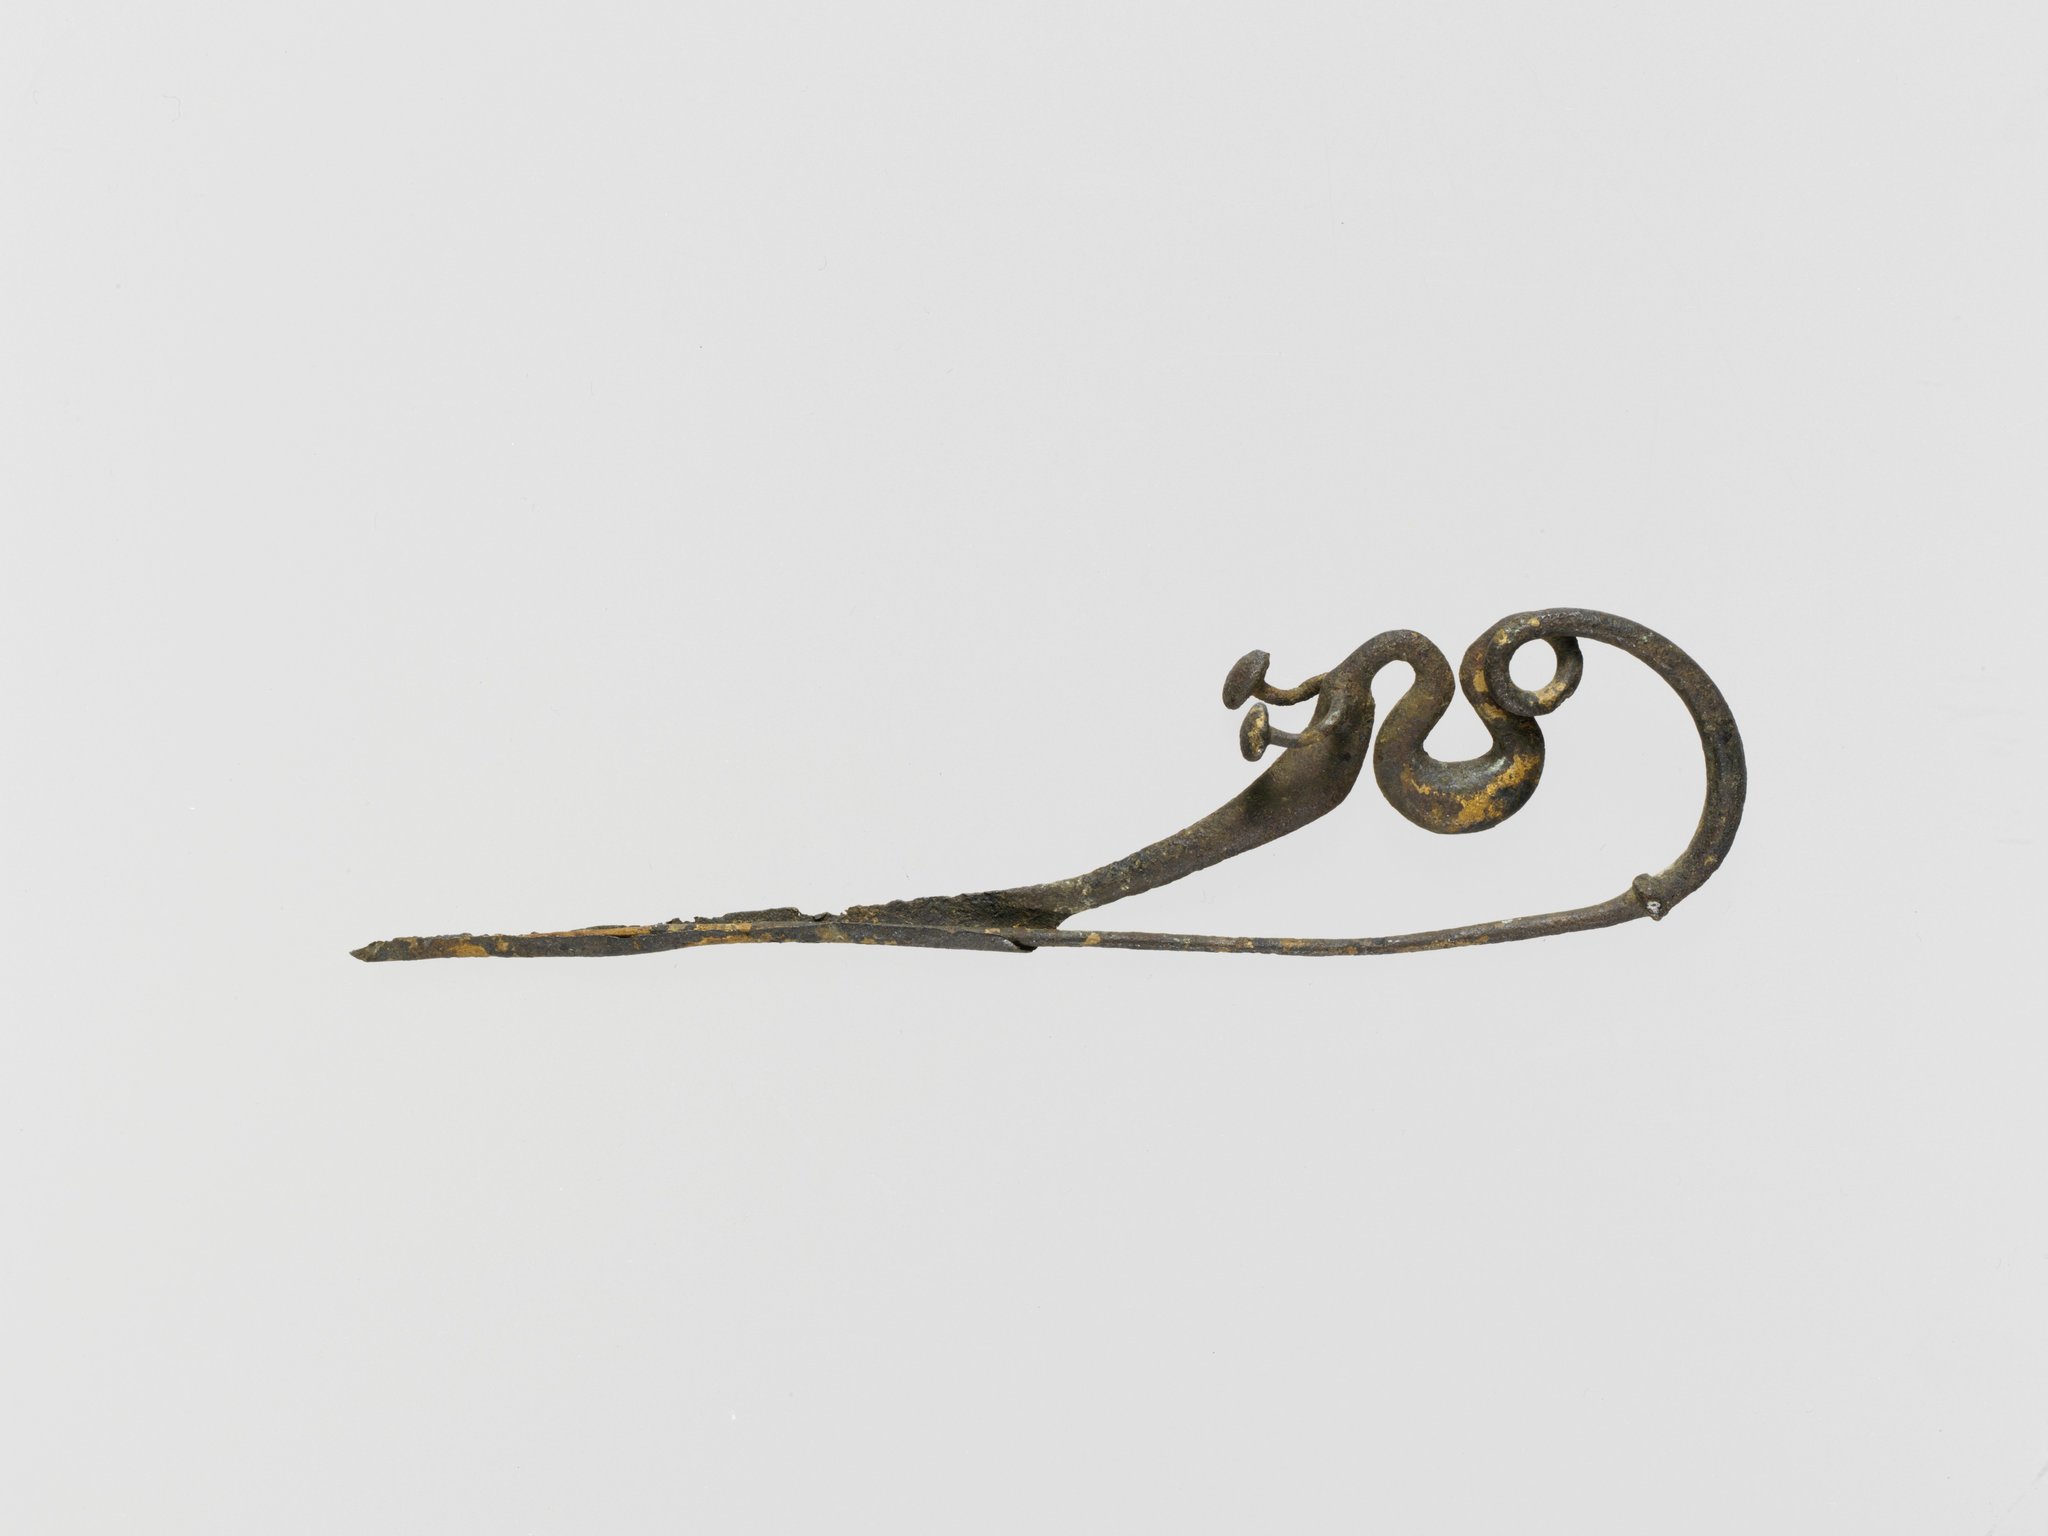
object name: fibula, serpentine type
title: Bronze dragon-type fibula (safety pin)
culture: etruscan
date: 700-650 BCE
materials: bronze